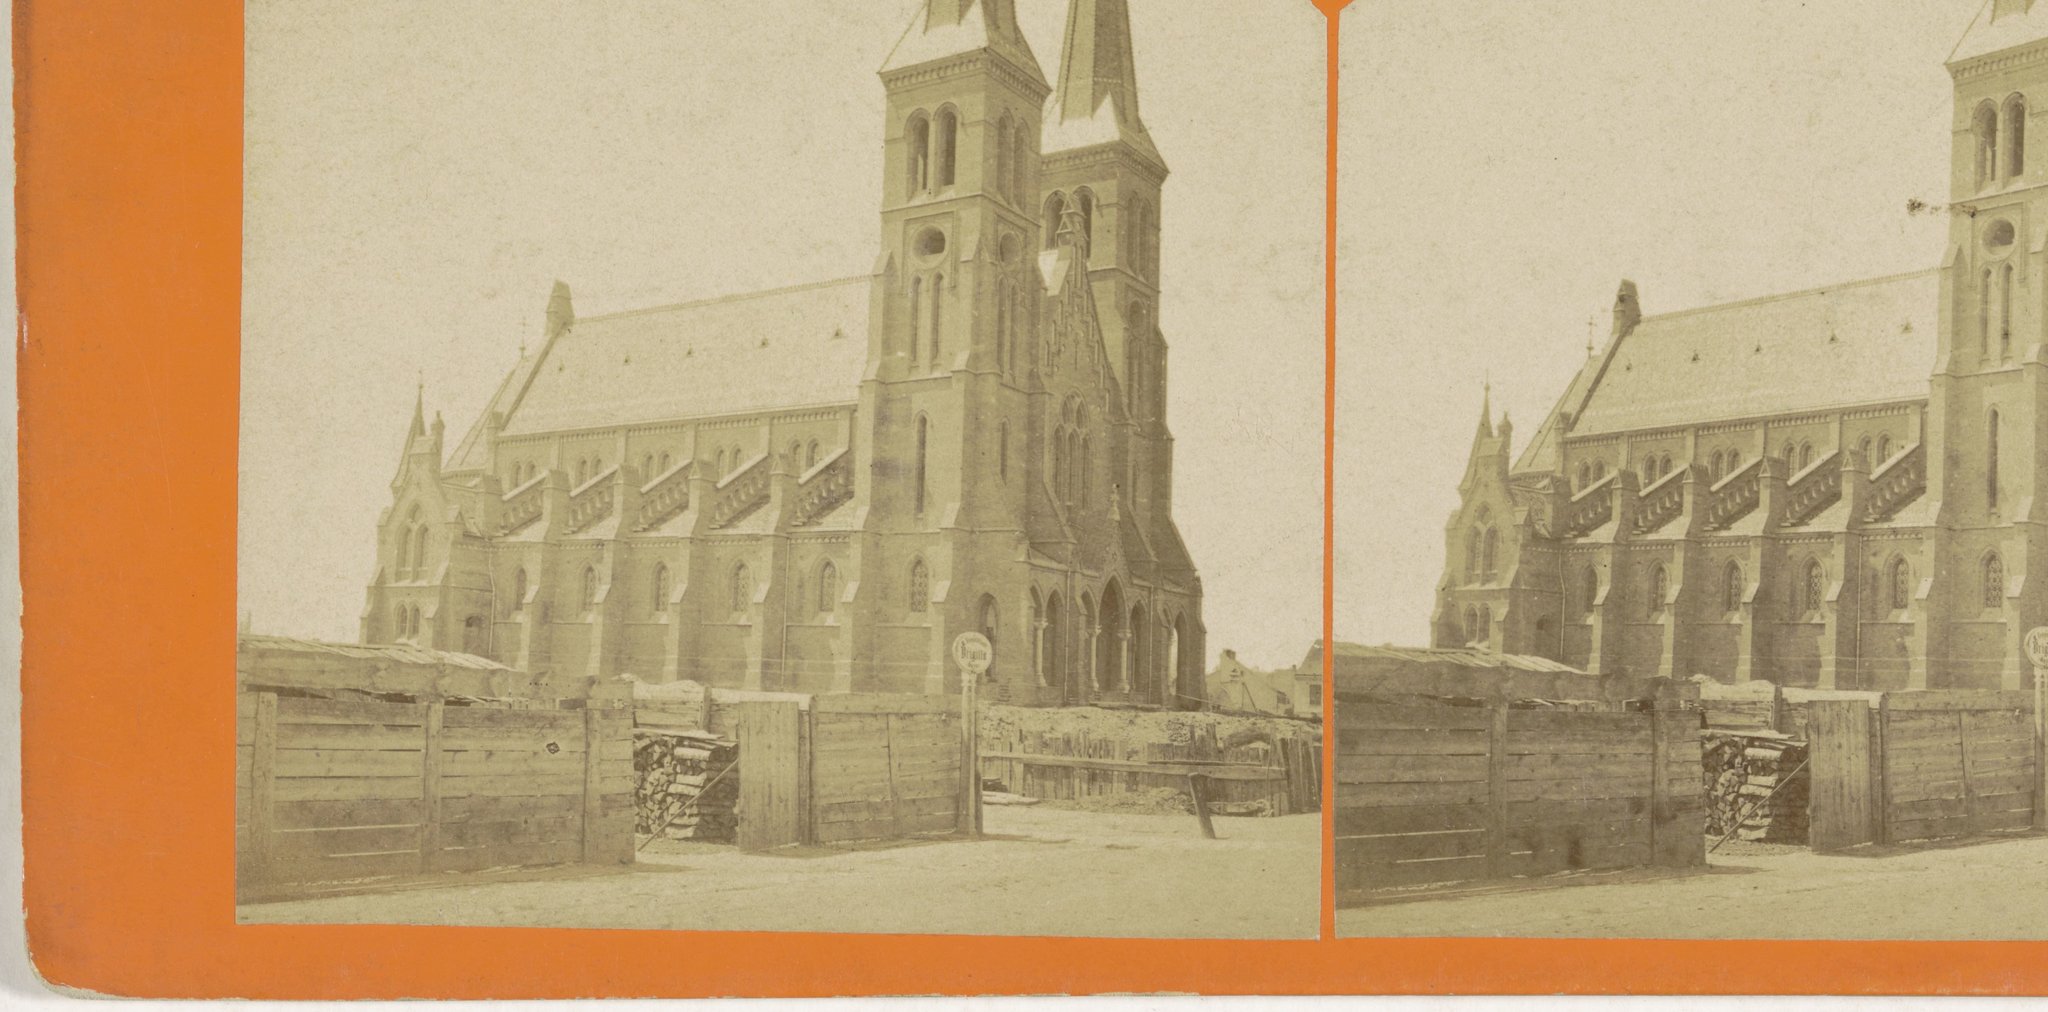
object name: stereograph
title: Brigittenkirche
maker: august angerer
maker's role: publisher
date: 1868-1890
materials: cardboard, paper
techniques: albumen print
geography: vienna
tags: church (exterior), vienna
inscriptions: inscription: ‘Nachdruck vorbehalten.’